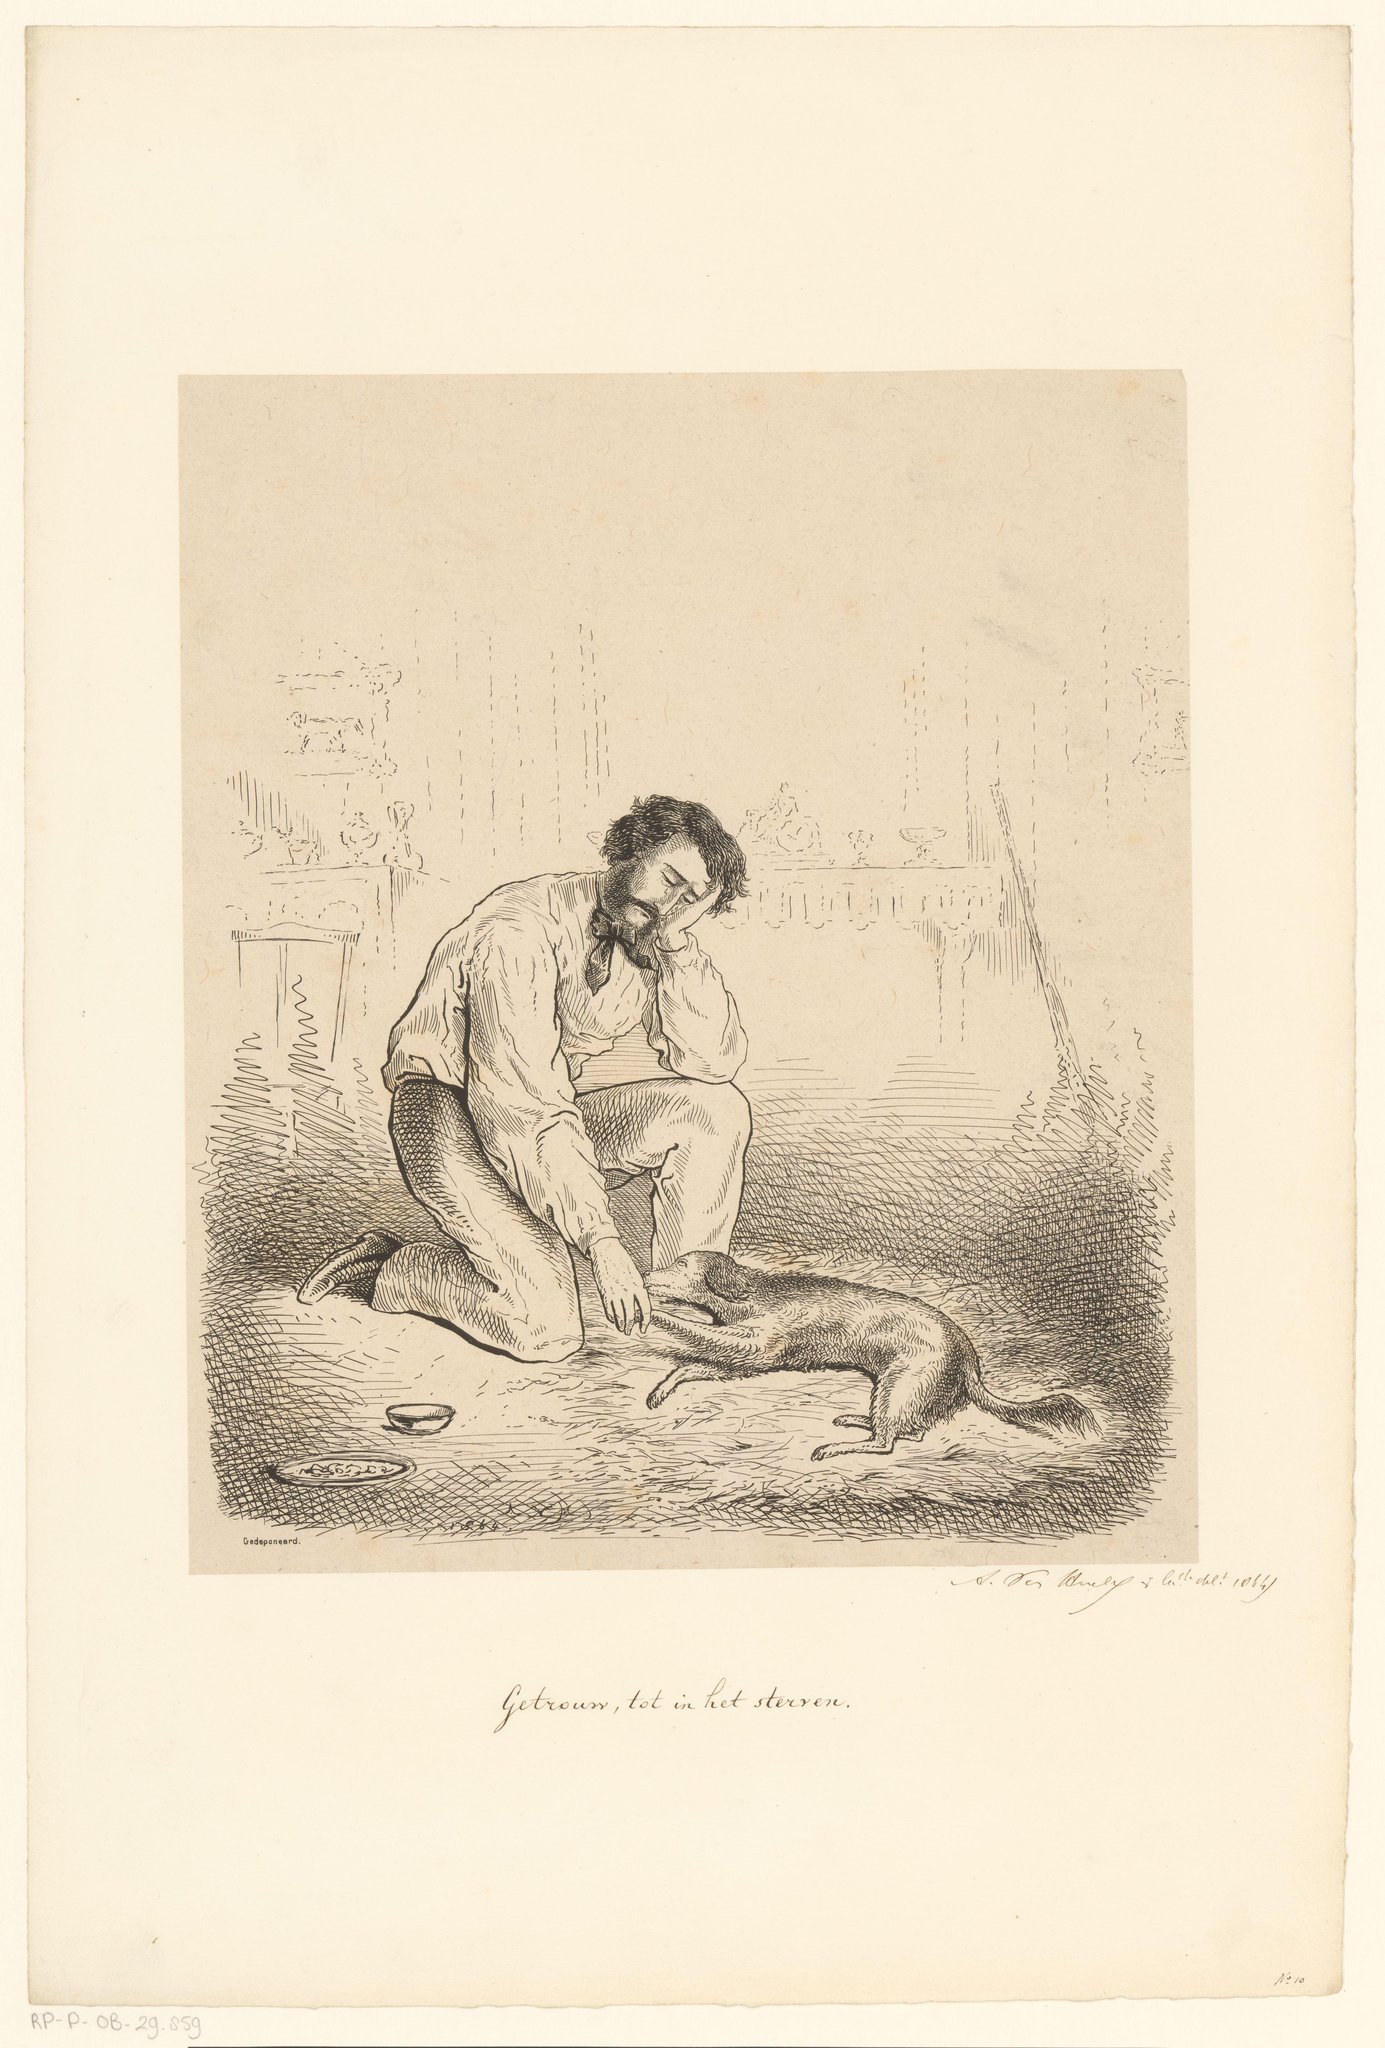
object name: print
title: Uit het verleden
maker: alexander ver huell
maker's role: draughtsman, print maker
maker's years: 1822-1897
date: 1864-1866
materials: paper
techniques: lithograph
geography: arnhem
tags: kneeling figure, dog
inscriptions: collector's mark: Lugt 2228, : ‘Gedeponeerd.’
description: Een droevige man knielt neer naast zijn stervende hond.